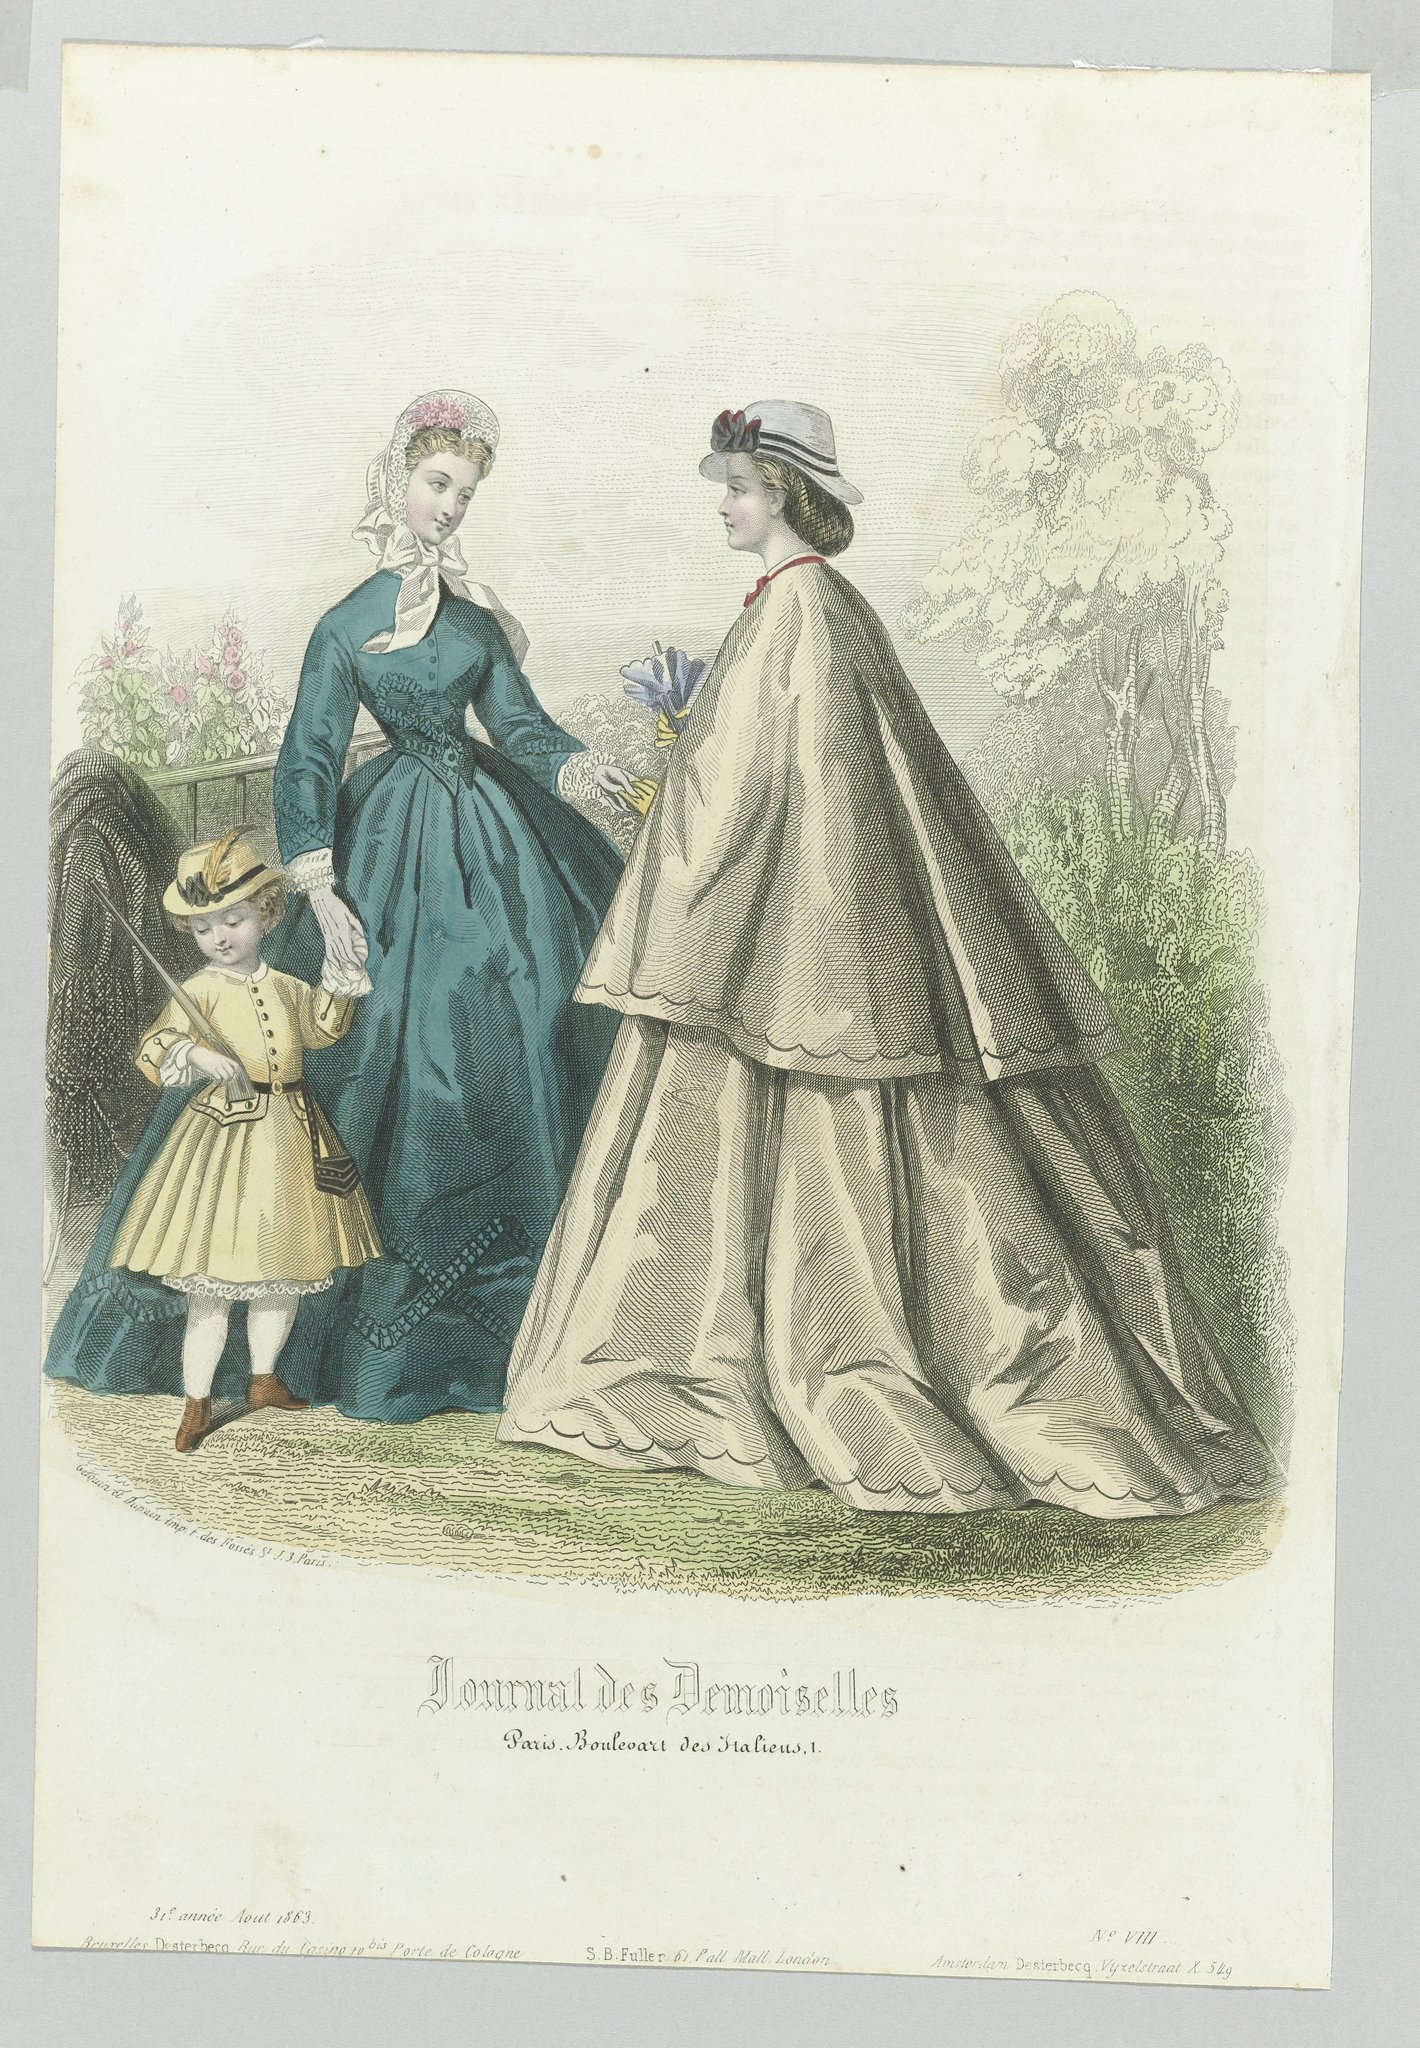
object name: fashion print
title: Journal des Demoiselles, août 1863, 31e année, No. 8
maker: Anonymous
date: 1863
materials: paper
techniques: engraving, hand coloring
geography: london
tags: bag (+ girls' clothes), head-gear: hat (+ girls' clothes), belt, girdle, waistband (+ girls' clothes), cape (+ women's clothes), fashion plates, head-gear: hat (+ women's clothes), skirt (+ women's clothes), gloves, mittens, etc. (+ women's clothes), (playing with) toys, dress, gown (+ girls' clothes)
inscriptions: address: ‘Paris, Boulevart des Italiens, 1. / Bruxelles Desterbecq Rue du Casino 10.bis Porte de Cologne / S.B. Fuller 61 Pall Mall London / Amsterdam Vijzelstraat X.549’, title: ‘Journal des Demoiselles’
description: Twee vrouwen in crinolinejapon. Één van hen heeft een kind aan de hand. Prent uit het modetijdschrift Journal des Demoiselles (1833 -1922).